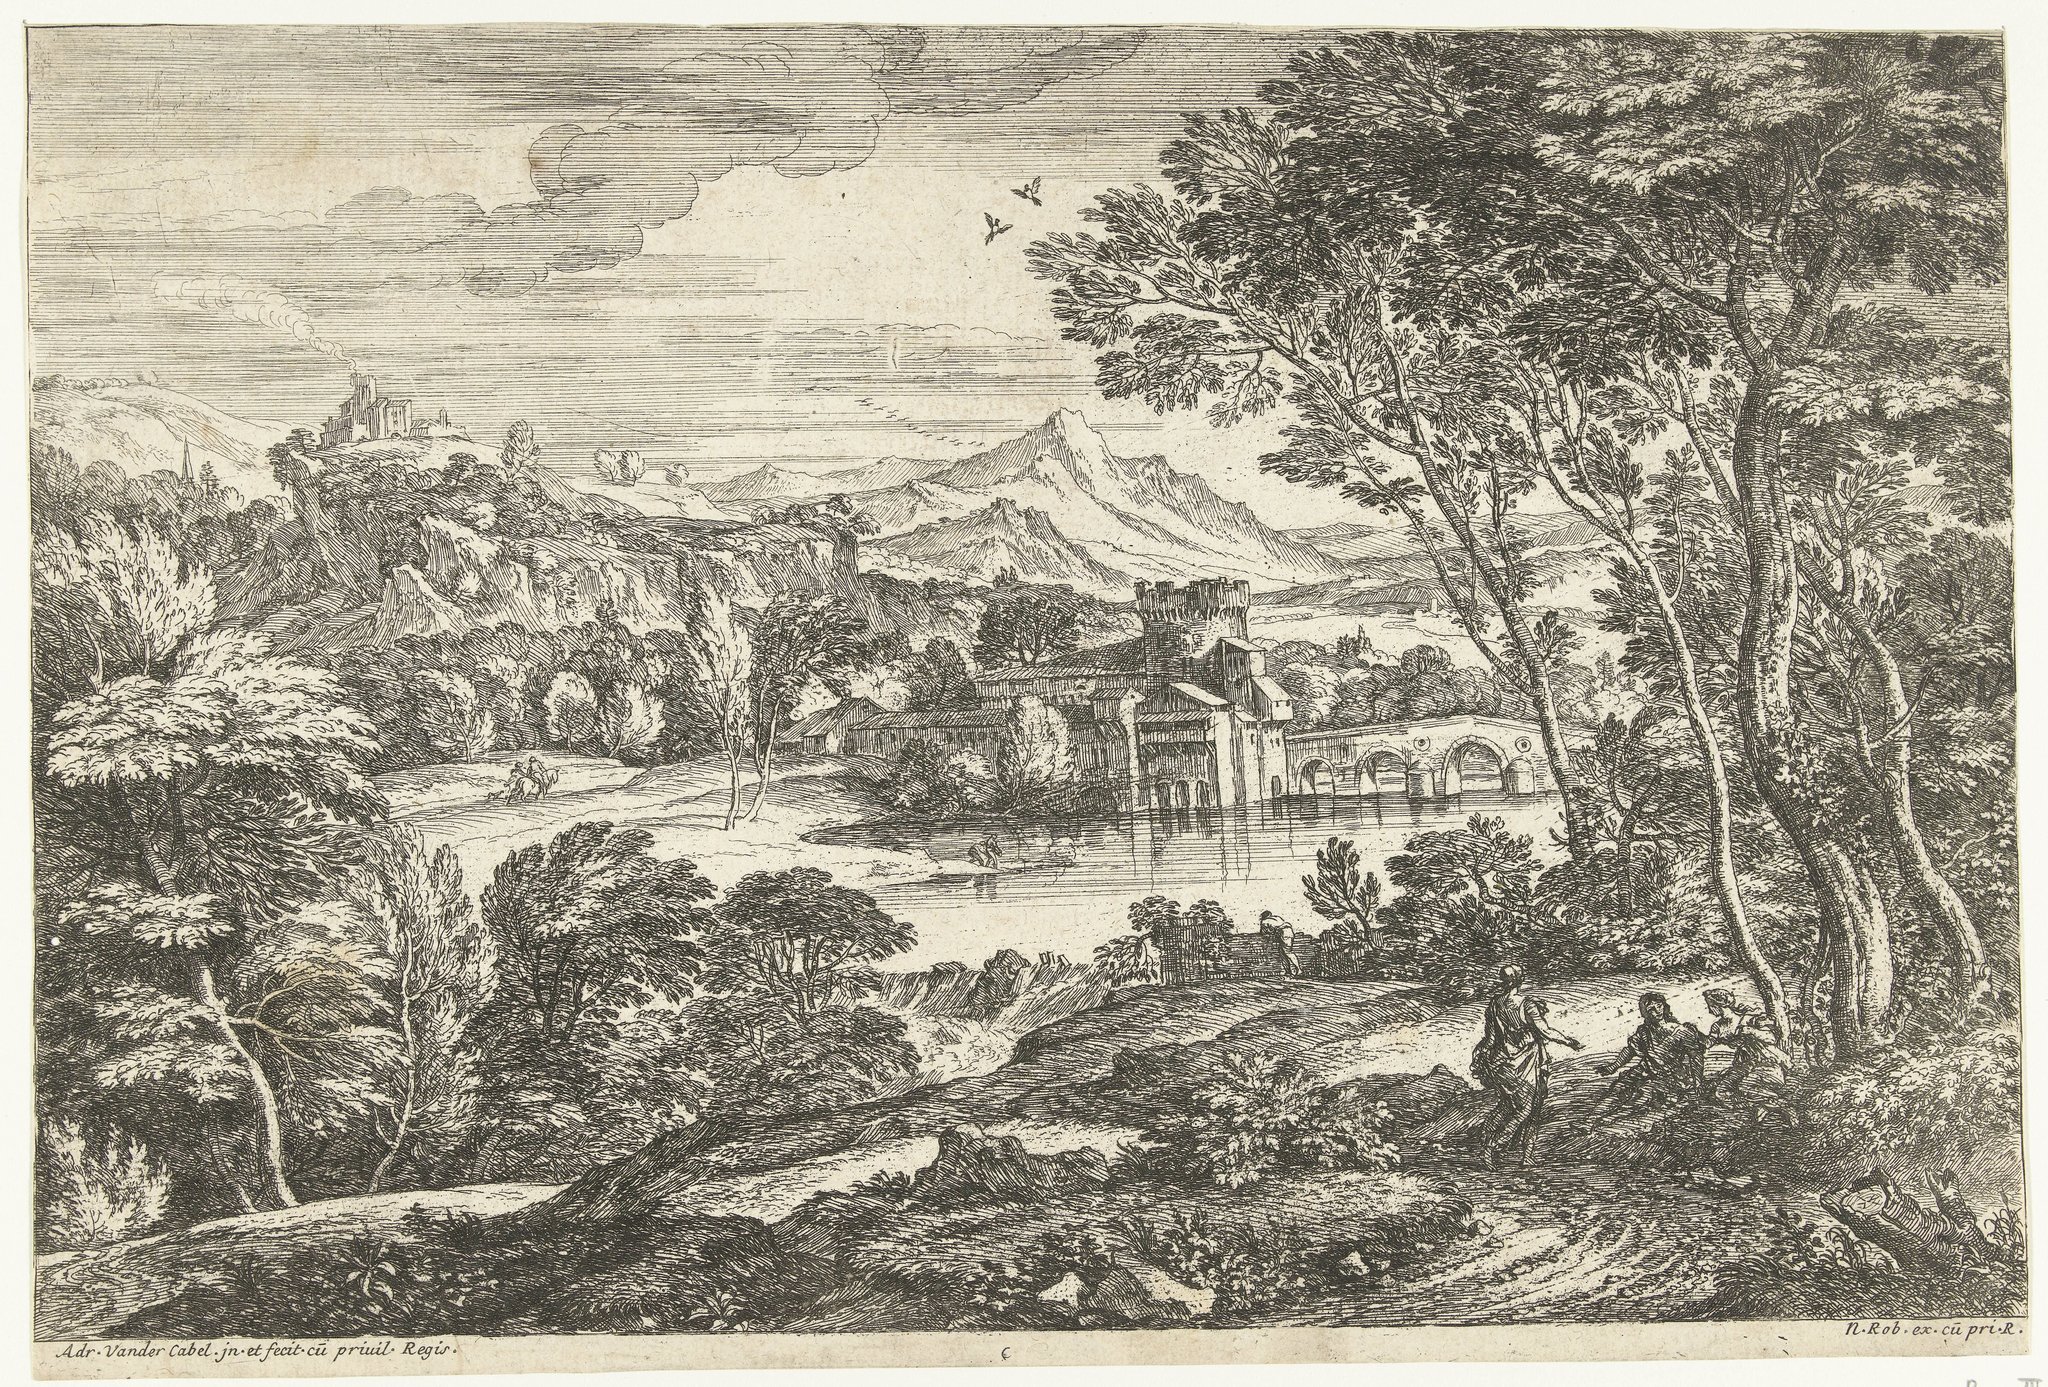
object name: print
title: Landschap met drie personen aan een pad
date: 1648-1705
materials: paper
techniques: etching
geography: france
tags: landscapes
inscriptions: collector's mark: Lugt 2228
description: Landschap met vrouw, staand bij aan pad zittende man en vrouw. Op de achtergrond een meer met brug naar kasteel.